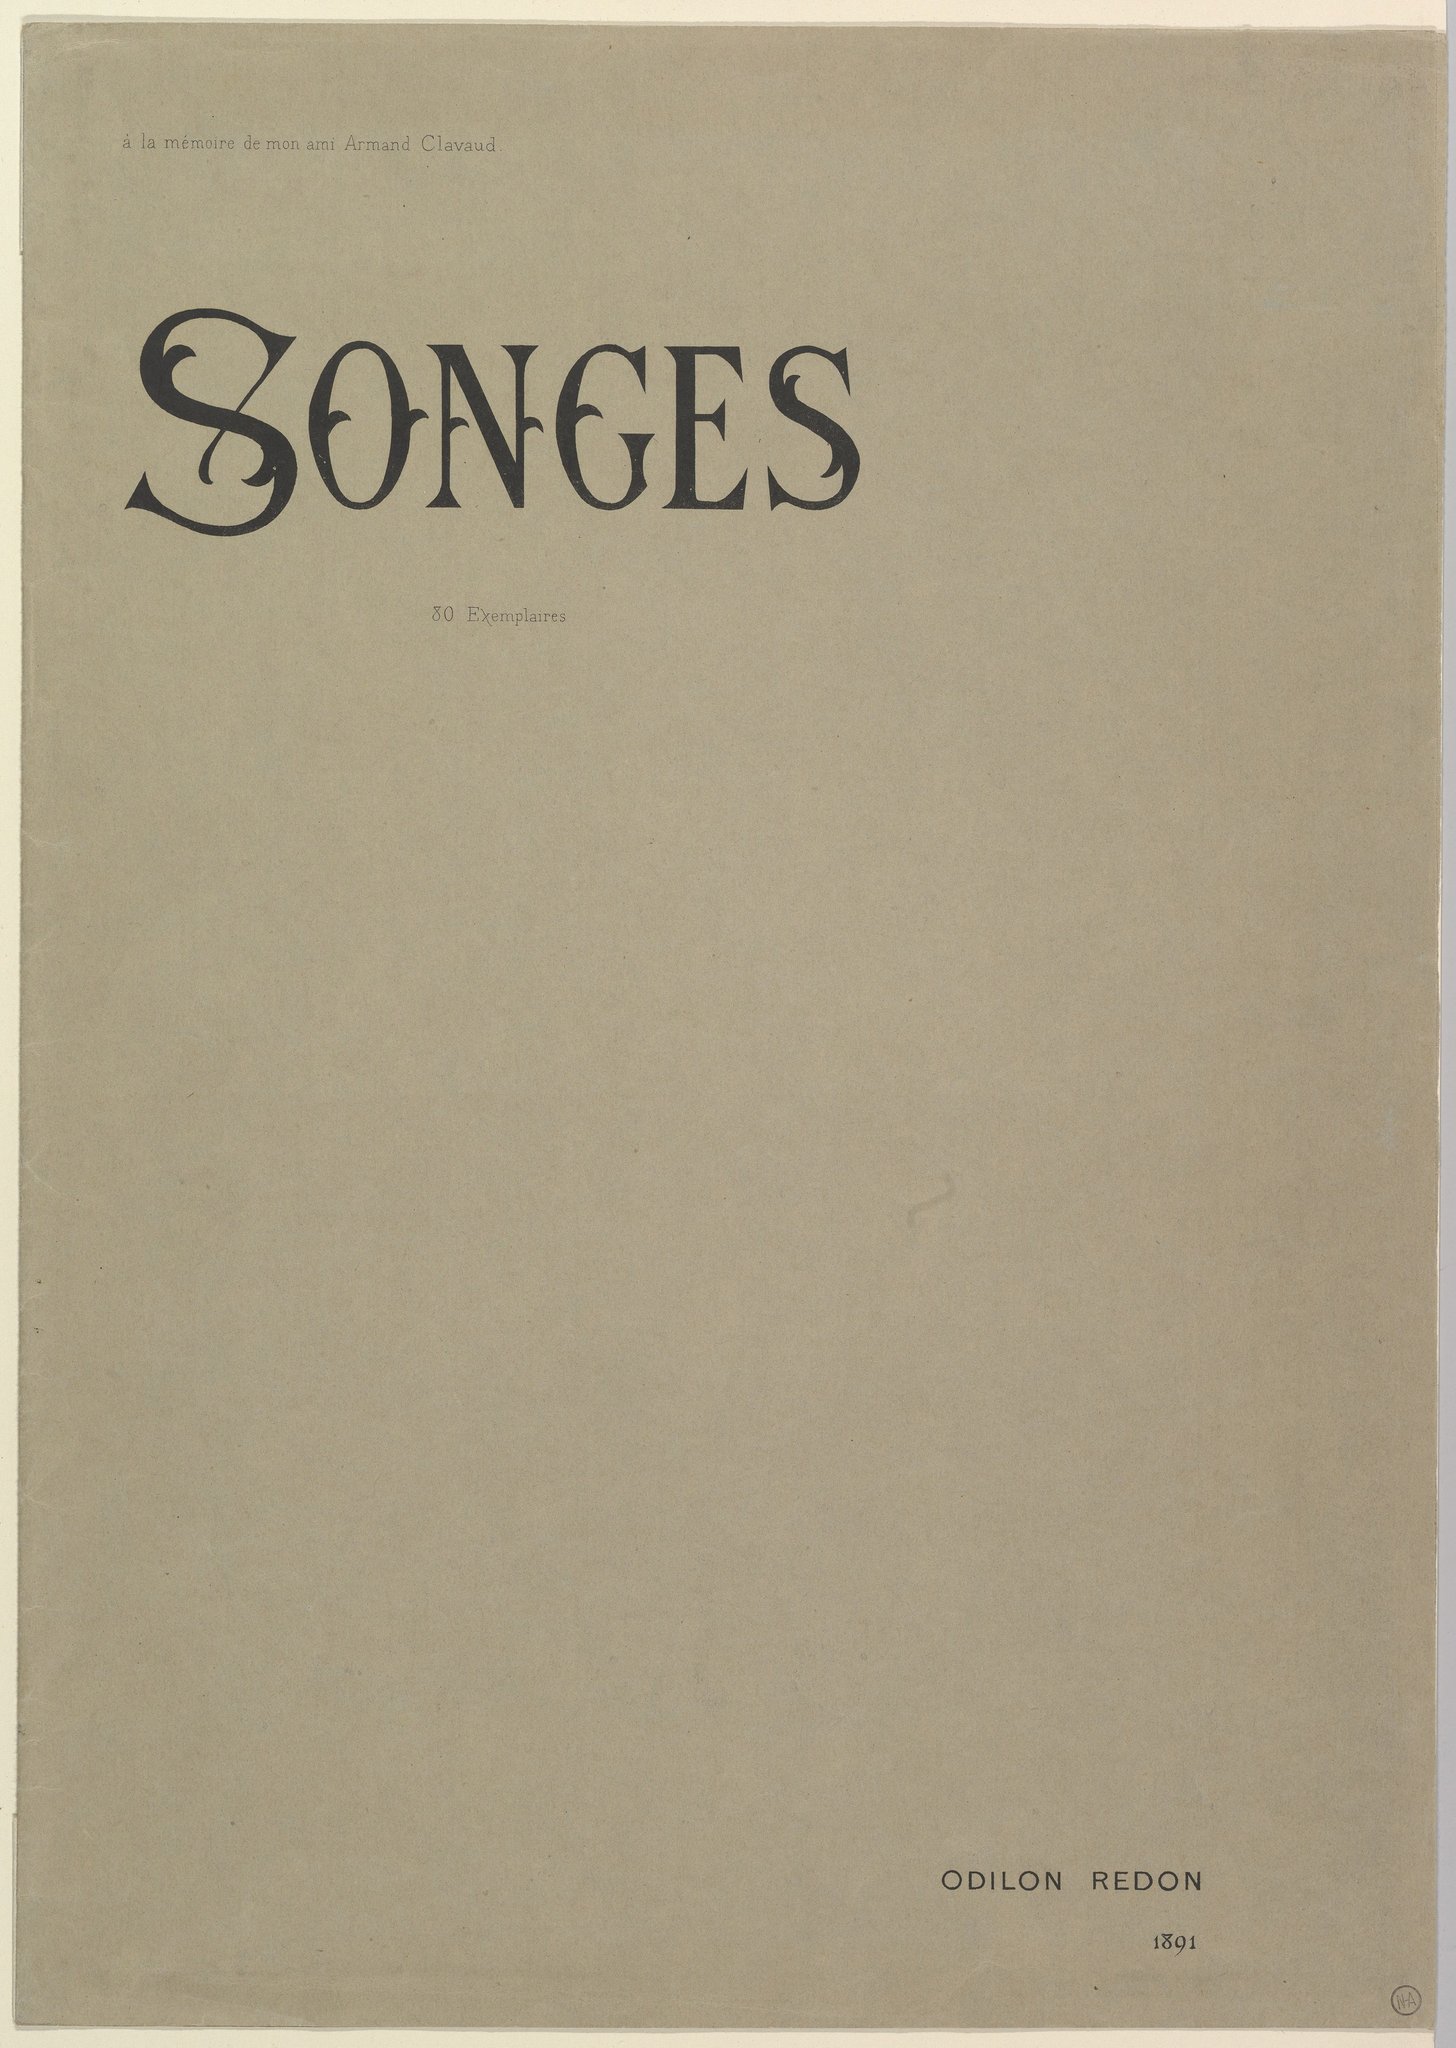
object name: print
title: Cover of Songes Album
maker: odilon redon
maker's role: artist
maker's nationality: french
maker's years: 1840-1916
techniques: lithograph